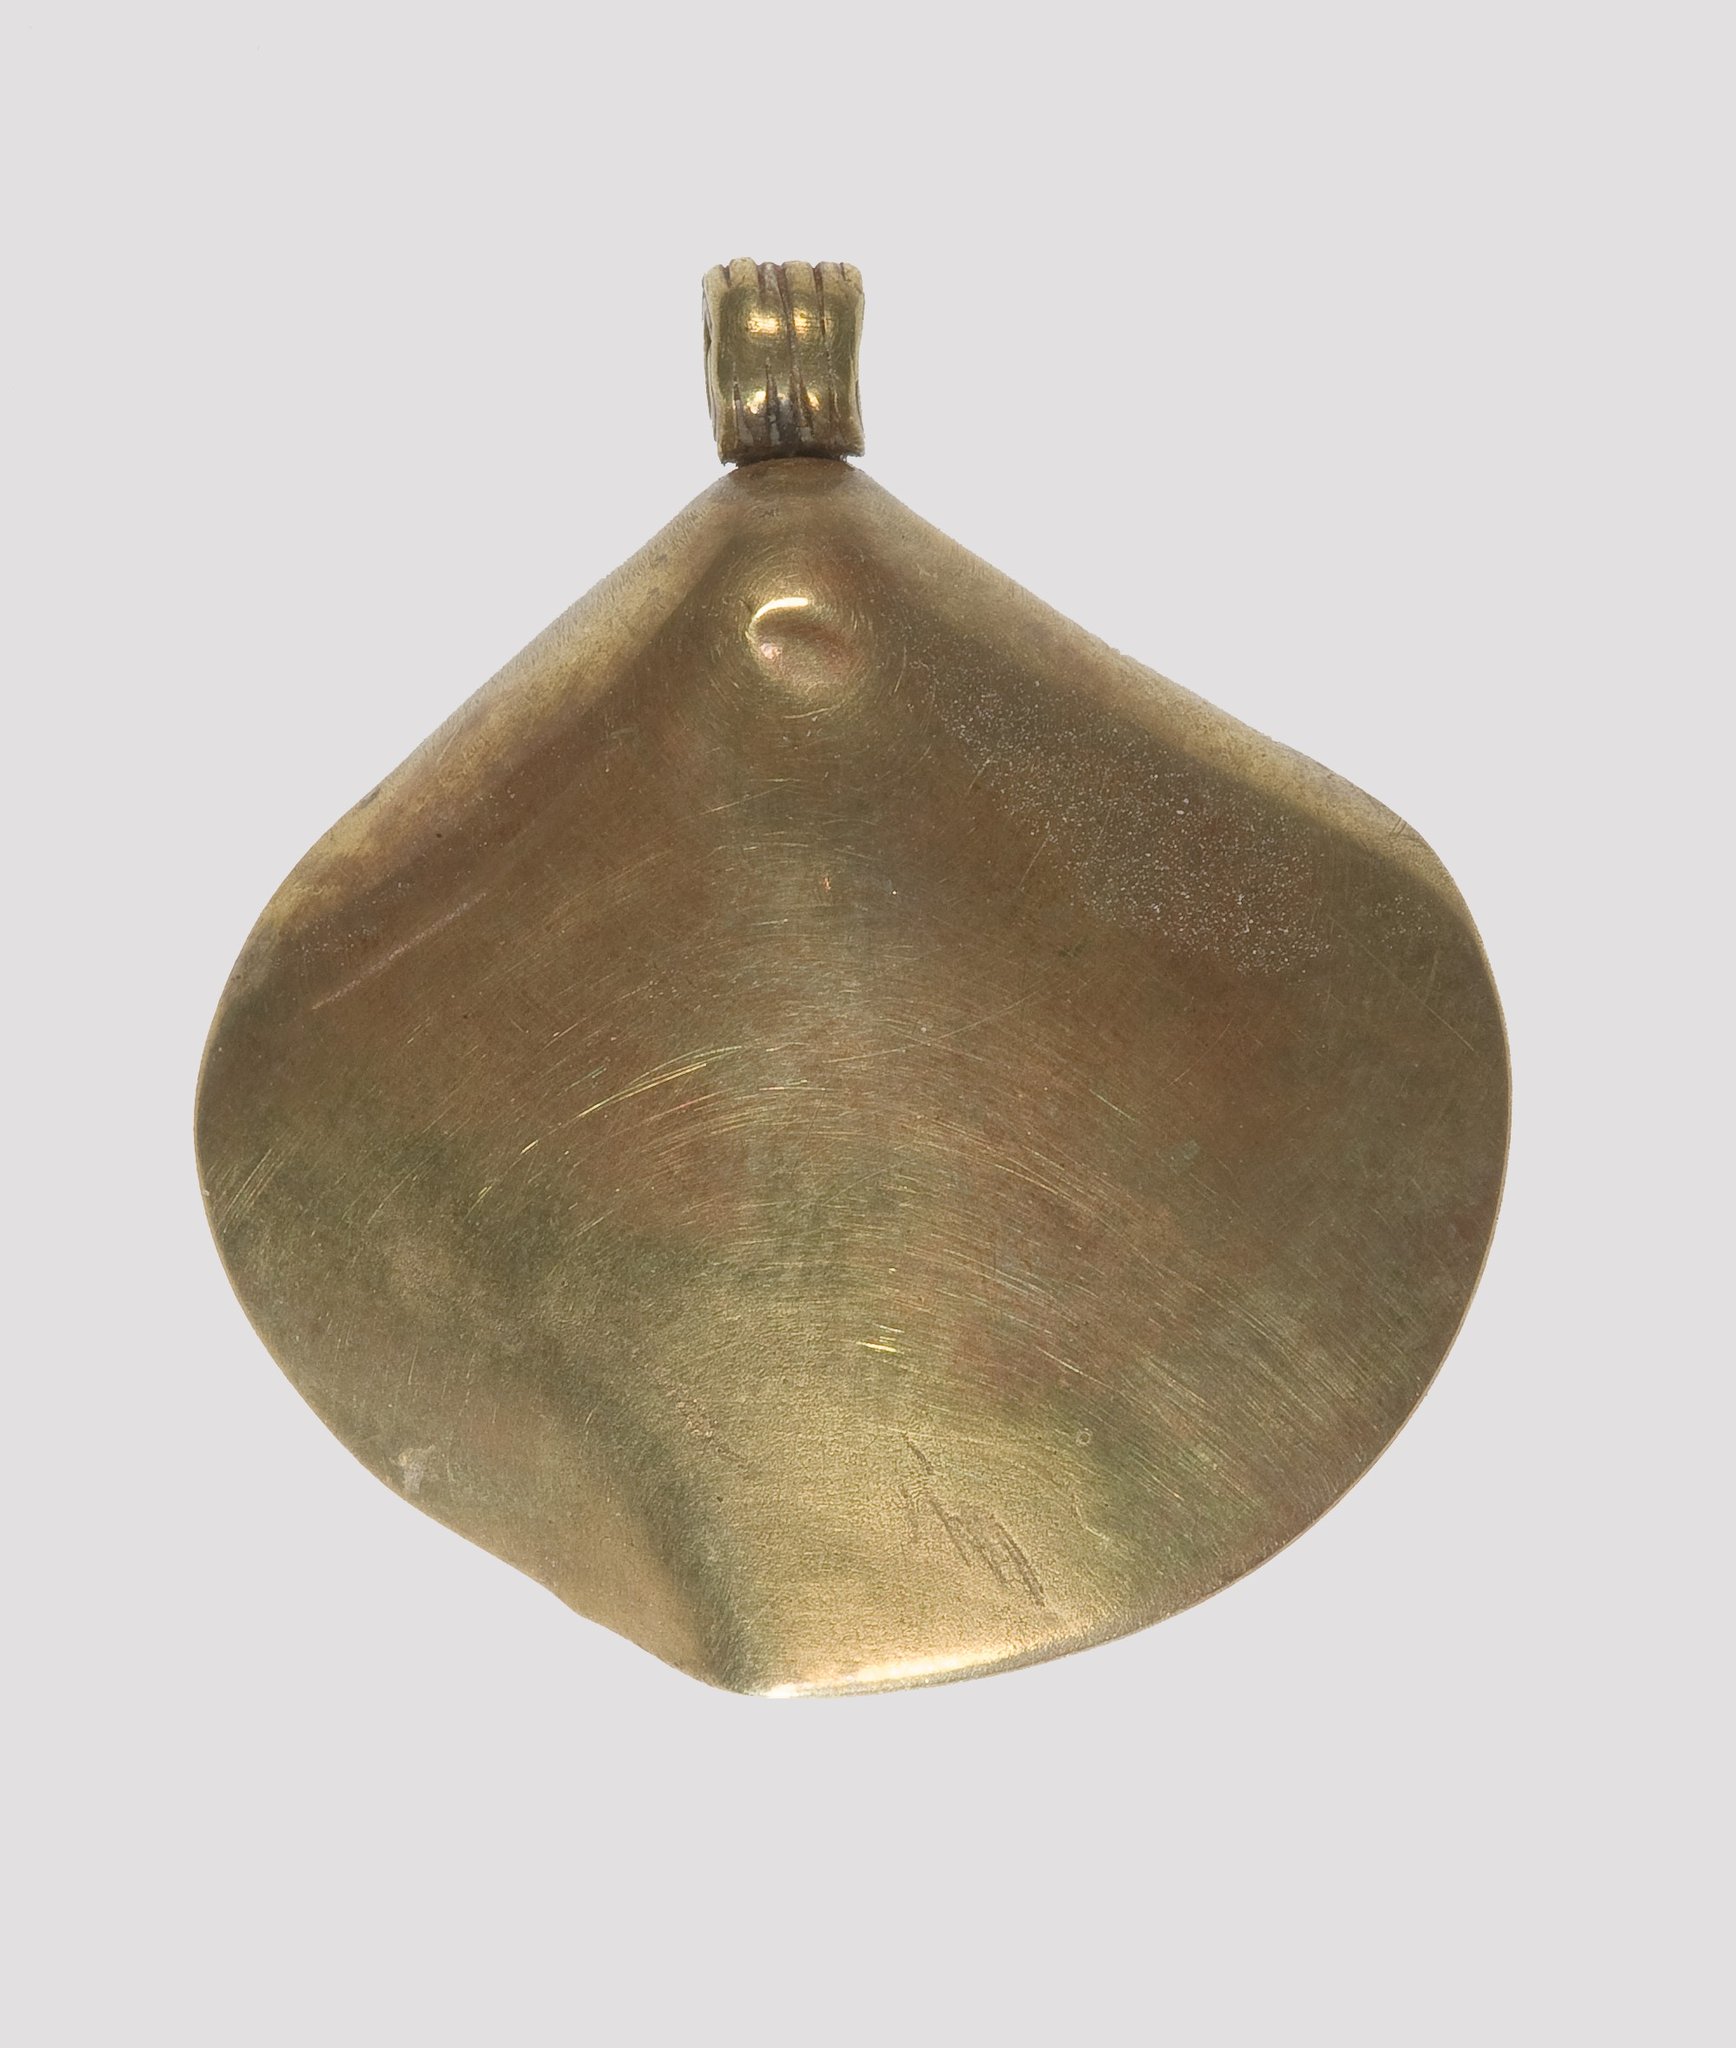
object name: pendant, shell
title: Pendant imitating a shell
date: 1981-1295 BCE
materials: gold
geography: egypt